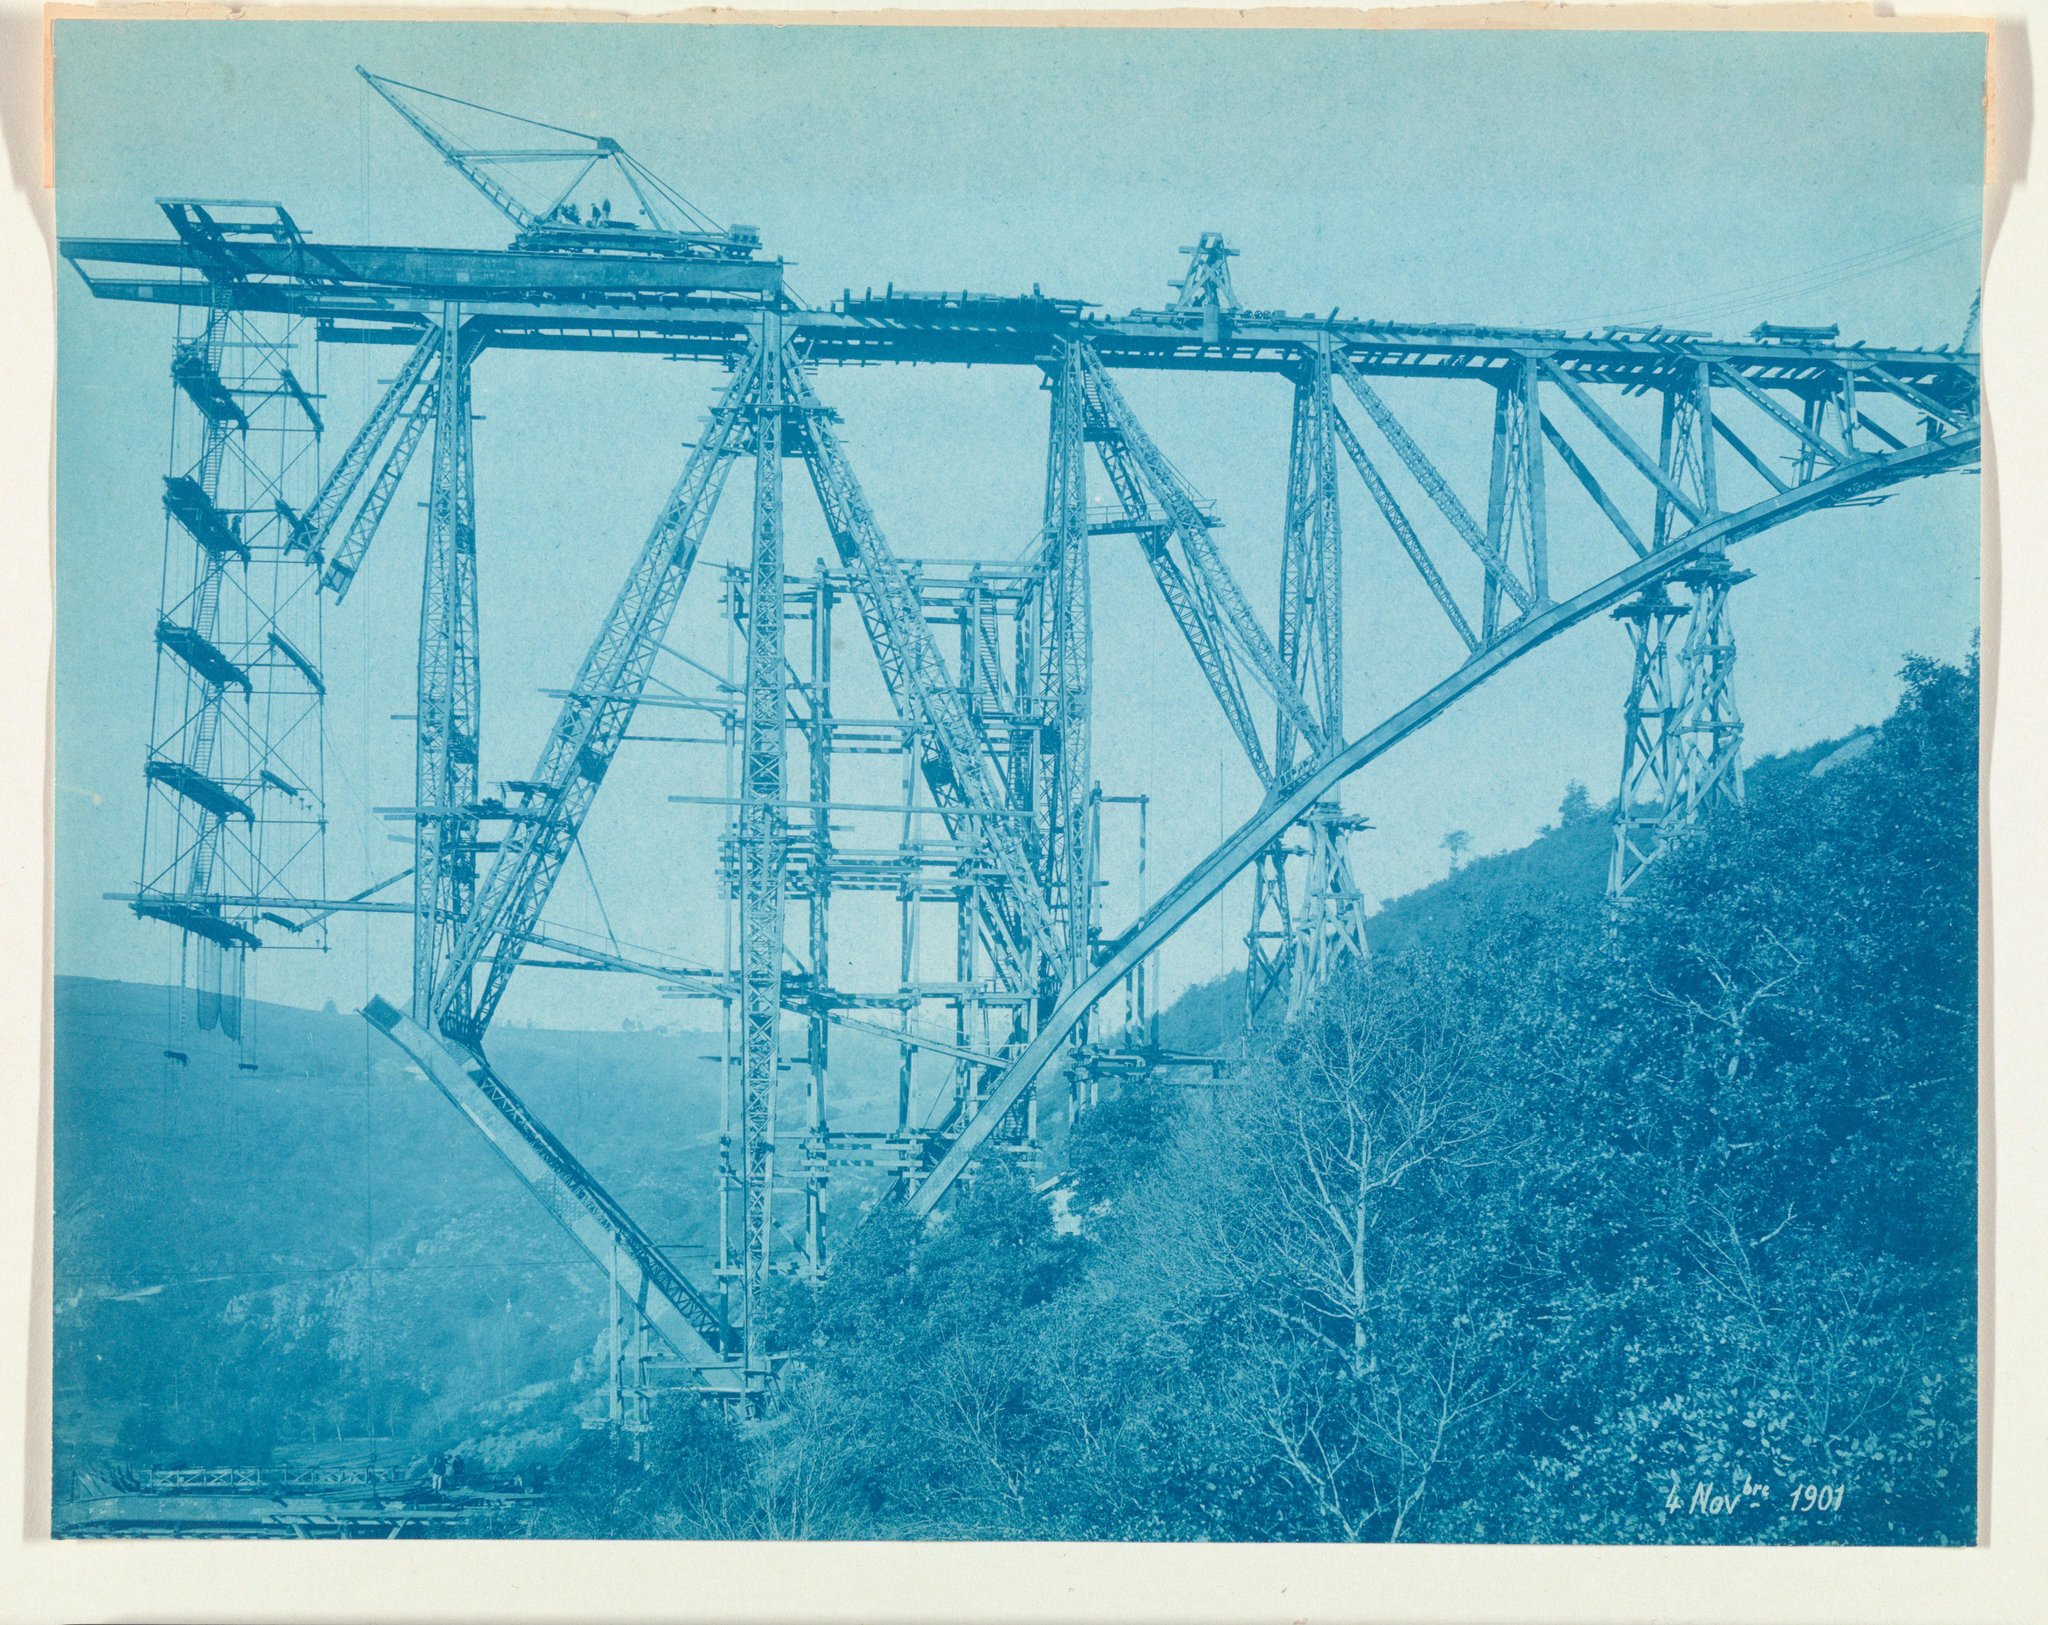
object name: photograph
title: Aanleg van het Viaur Viaduct in Frankrijk door de Societé de Construction des Battignolles, 4 november 1901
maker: Anonymous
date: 1901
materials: photographic support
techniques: cyanotype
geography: france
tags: viaduct, making the overground structures (~ building activities)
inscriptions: date